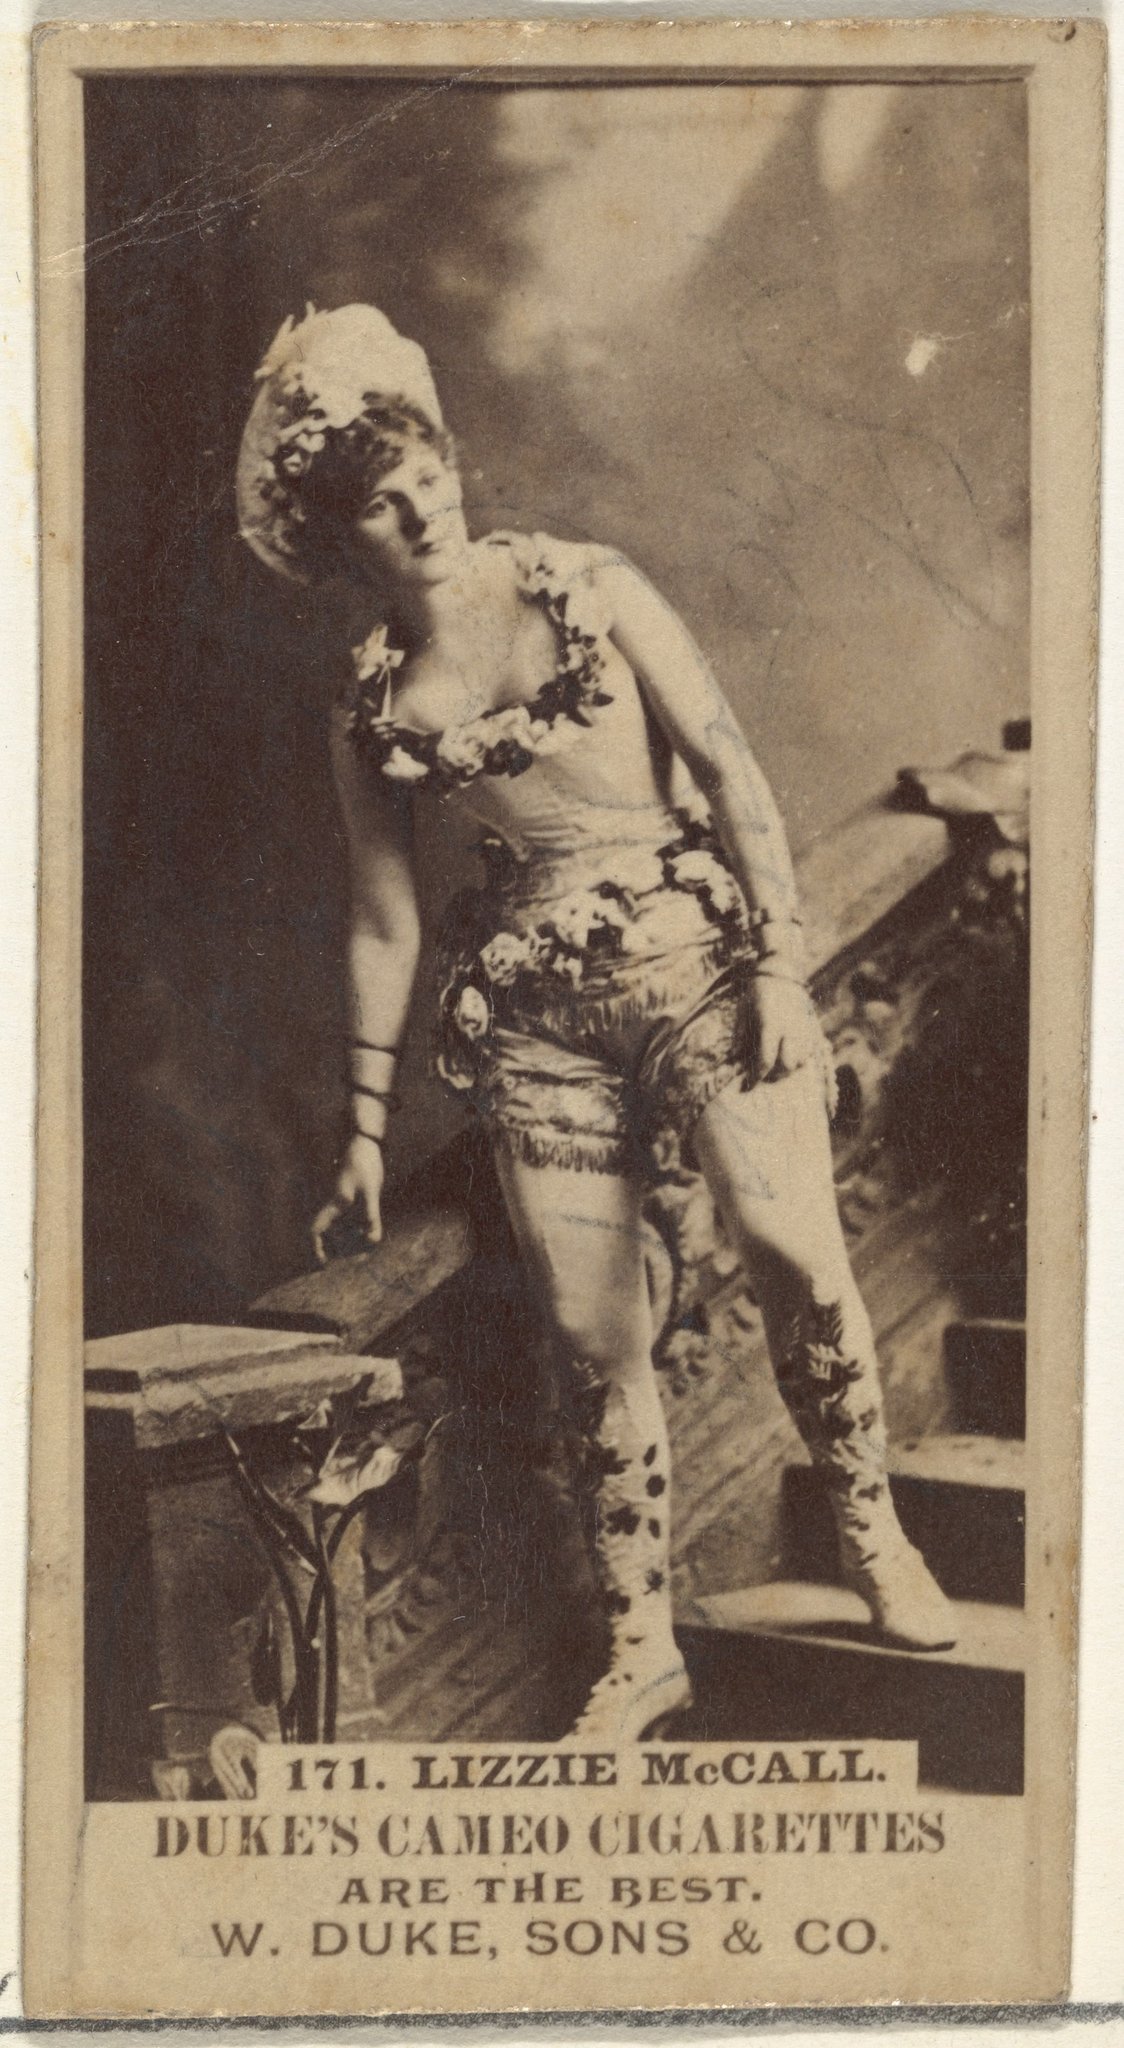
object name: photograph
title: Card Number 171, Lizzie McCall, from the Actors and Actresses series (N145-5) issued by Duke Sons & Co. to promote Cameo Cigarettes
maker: w. duke, sons & co.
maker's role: publisher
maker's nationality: american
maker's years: 1870-1920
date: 1880-1889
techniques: albumen silver print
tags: portraits,women,actresses